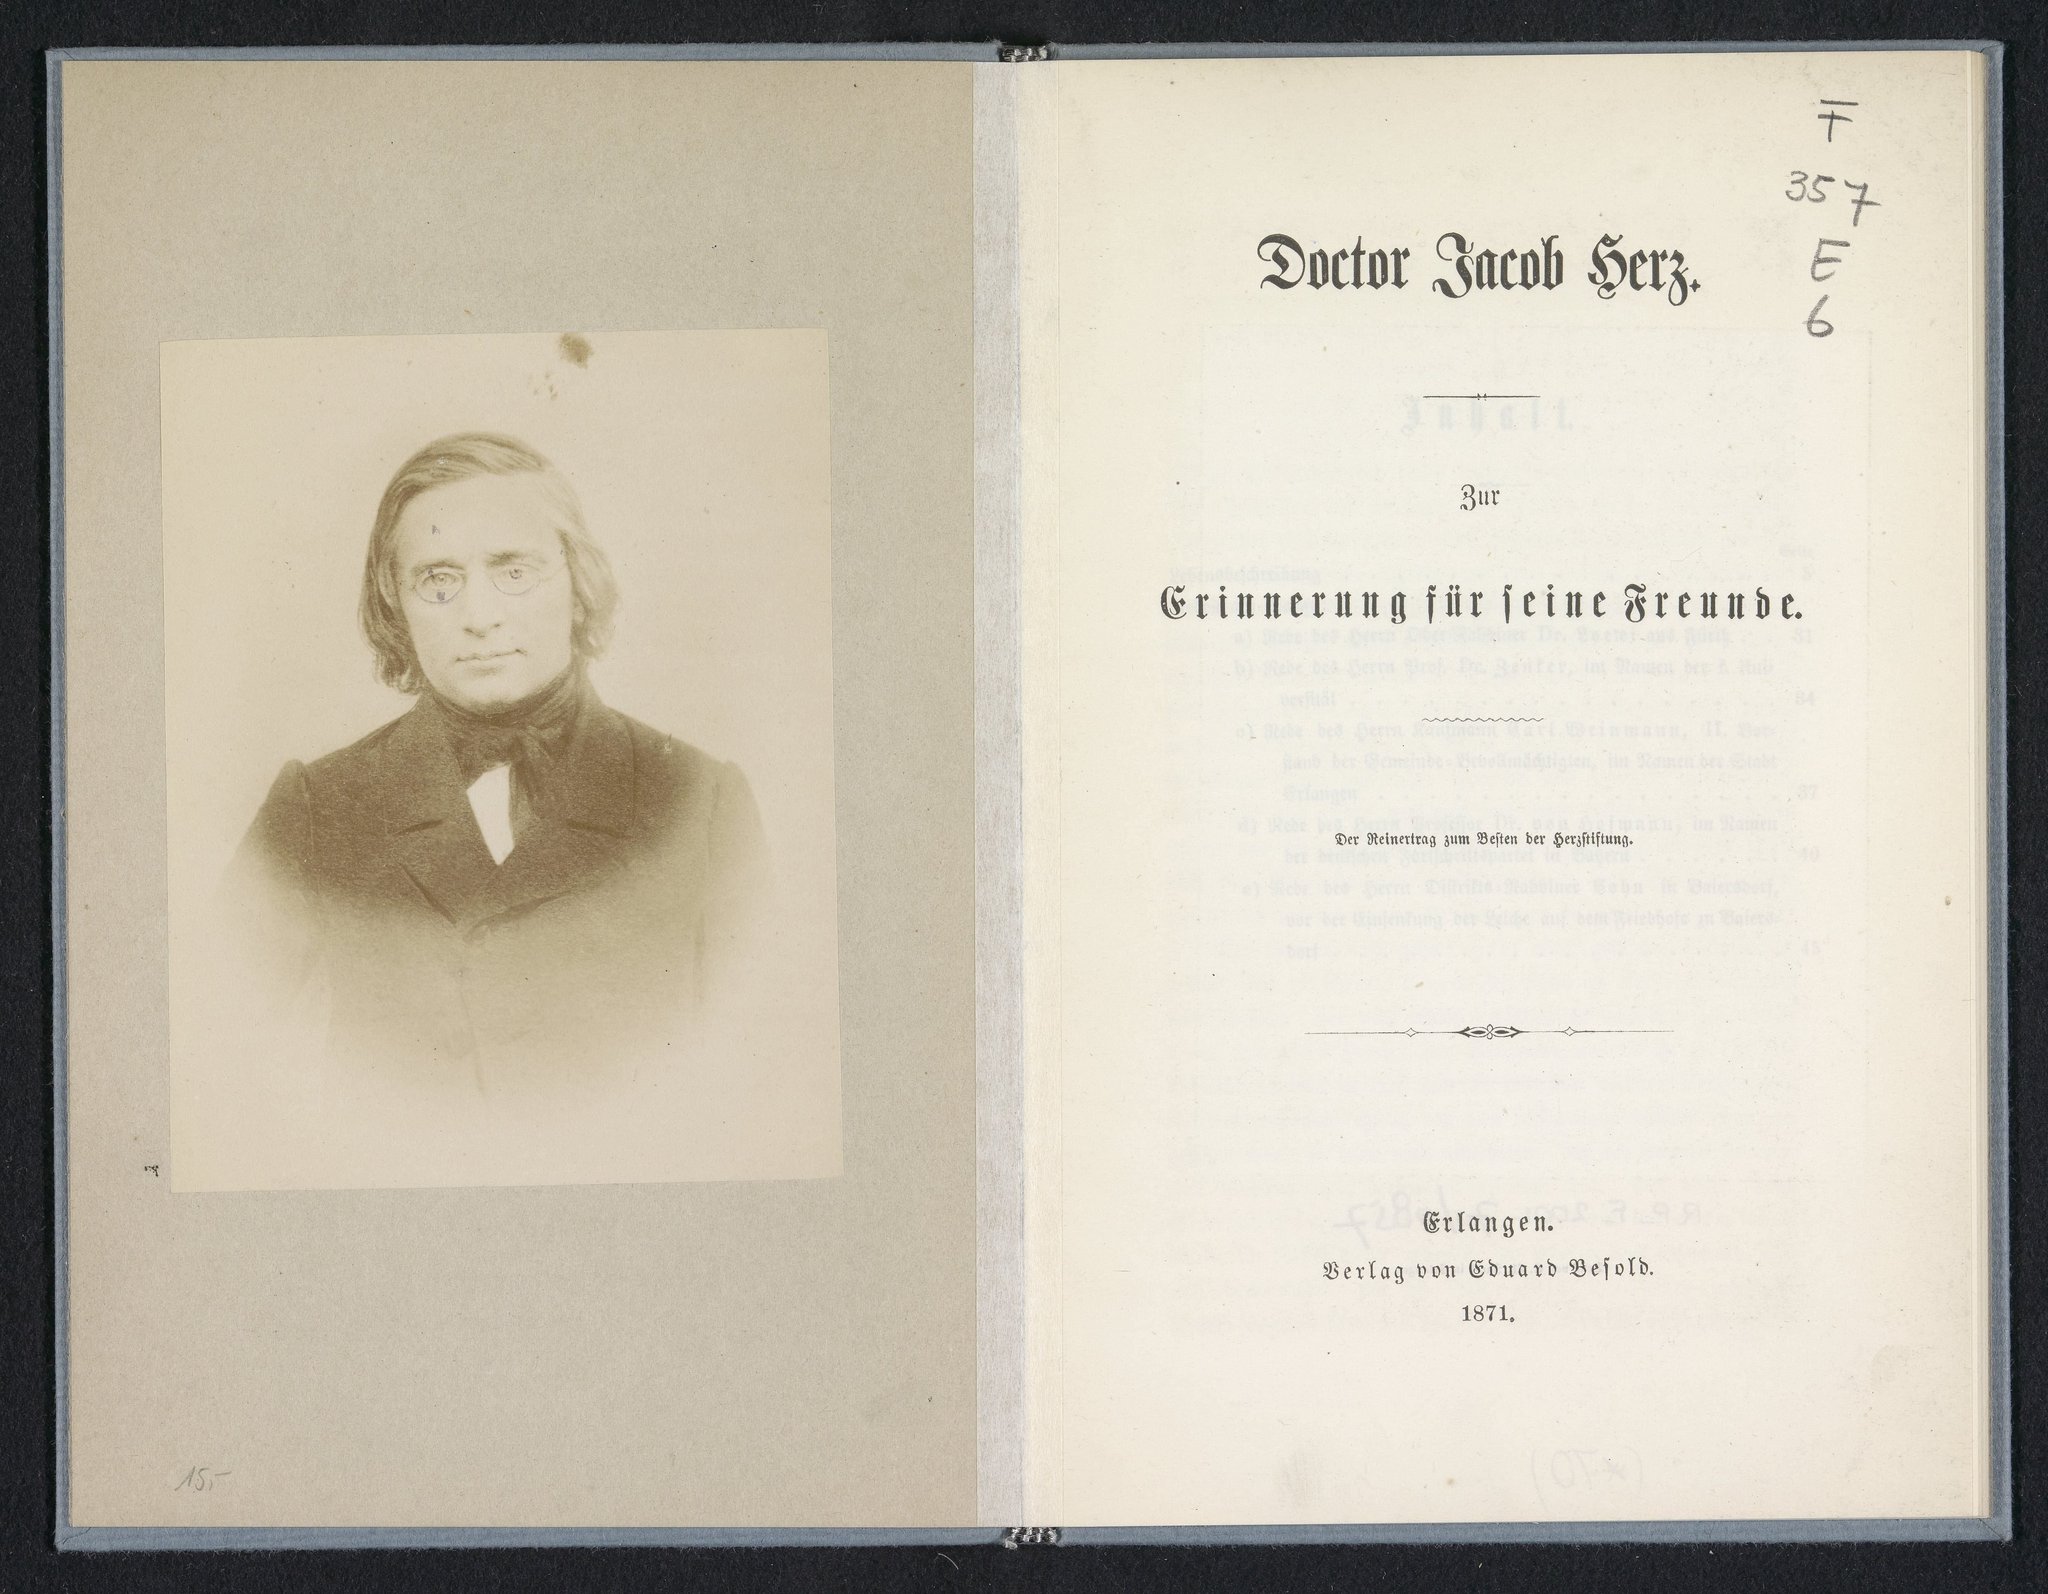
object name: photograph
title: Portret van Jakob Herz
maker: Anonymous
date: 1861-1871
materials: photographic support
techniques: albumen print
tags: physician, doctor